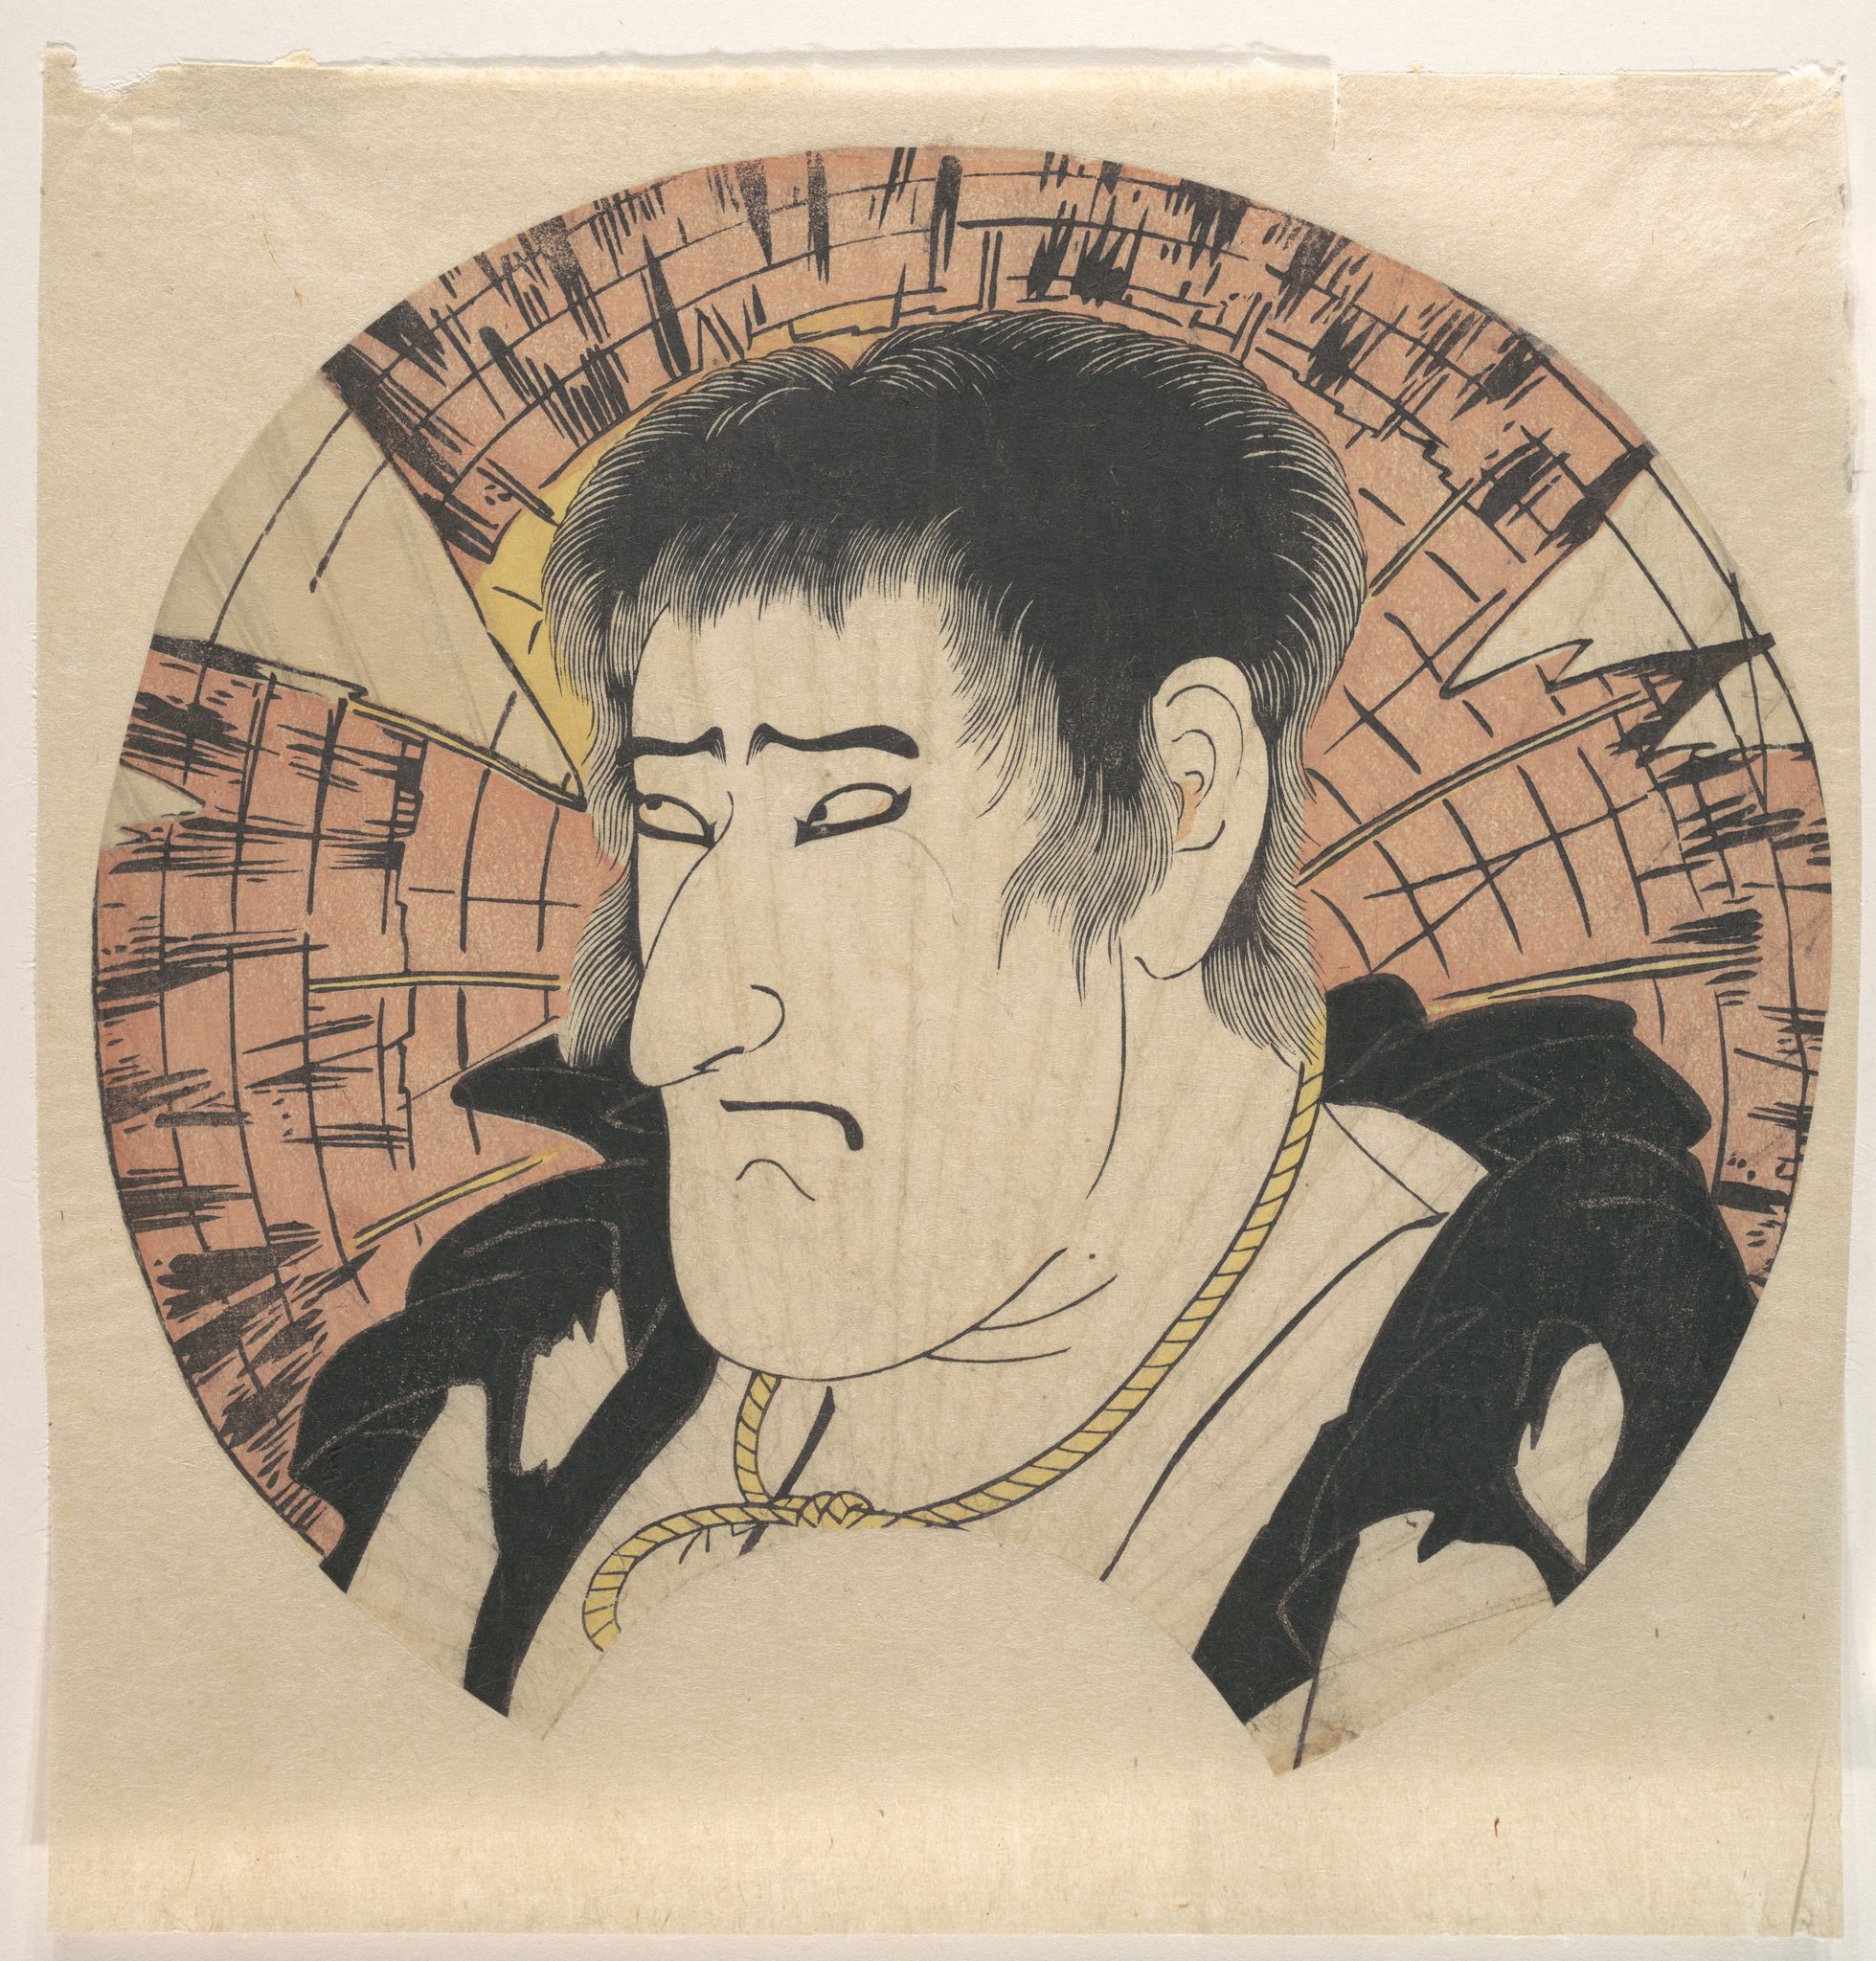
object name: woodblock print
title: Head of an Unidentified Actor as a countryman in Rags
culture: japanese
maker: katsukawa shun'ei 勝川春英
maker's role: artist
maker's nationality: japanese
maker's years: 1762-1819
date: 1793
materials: ink, paper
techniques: woodblock print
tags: heads,actors